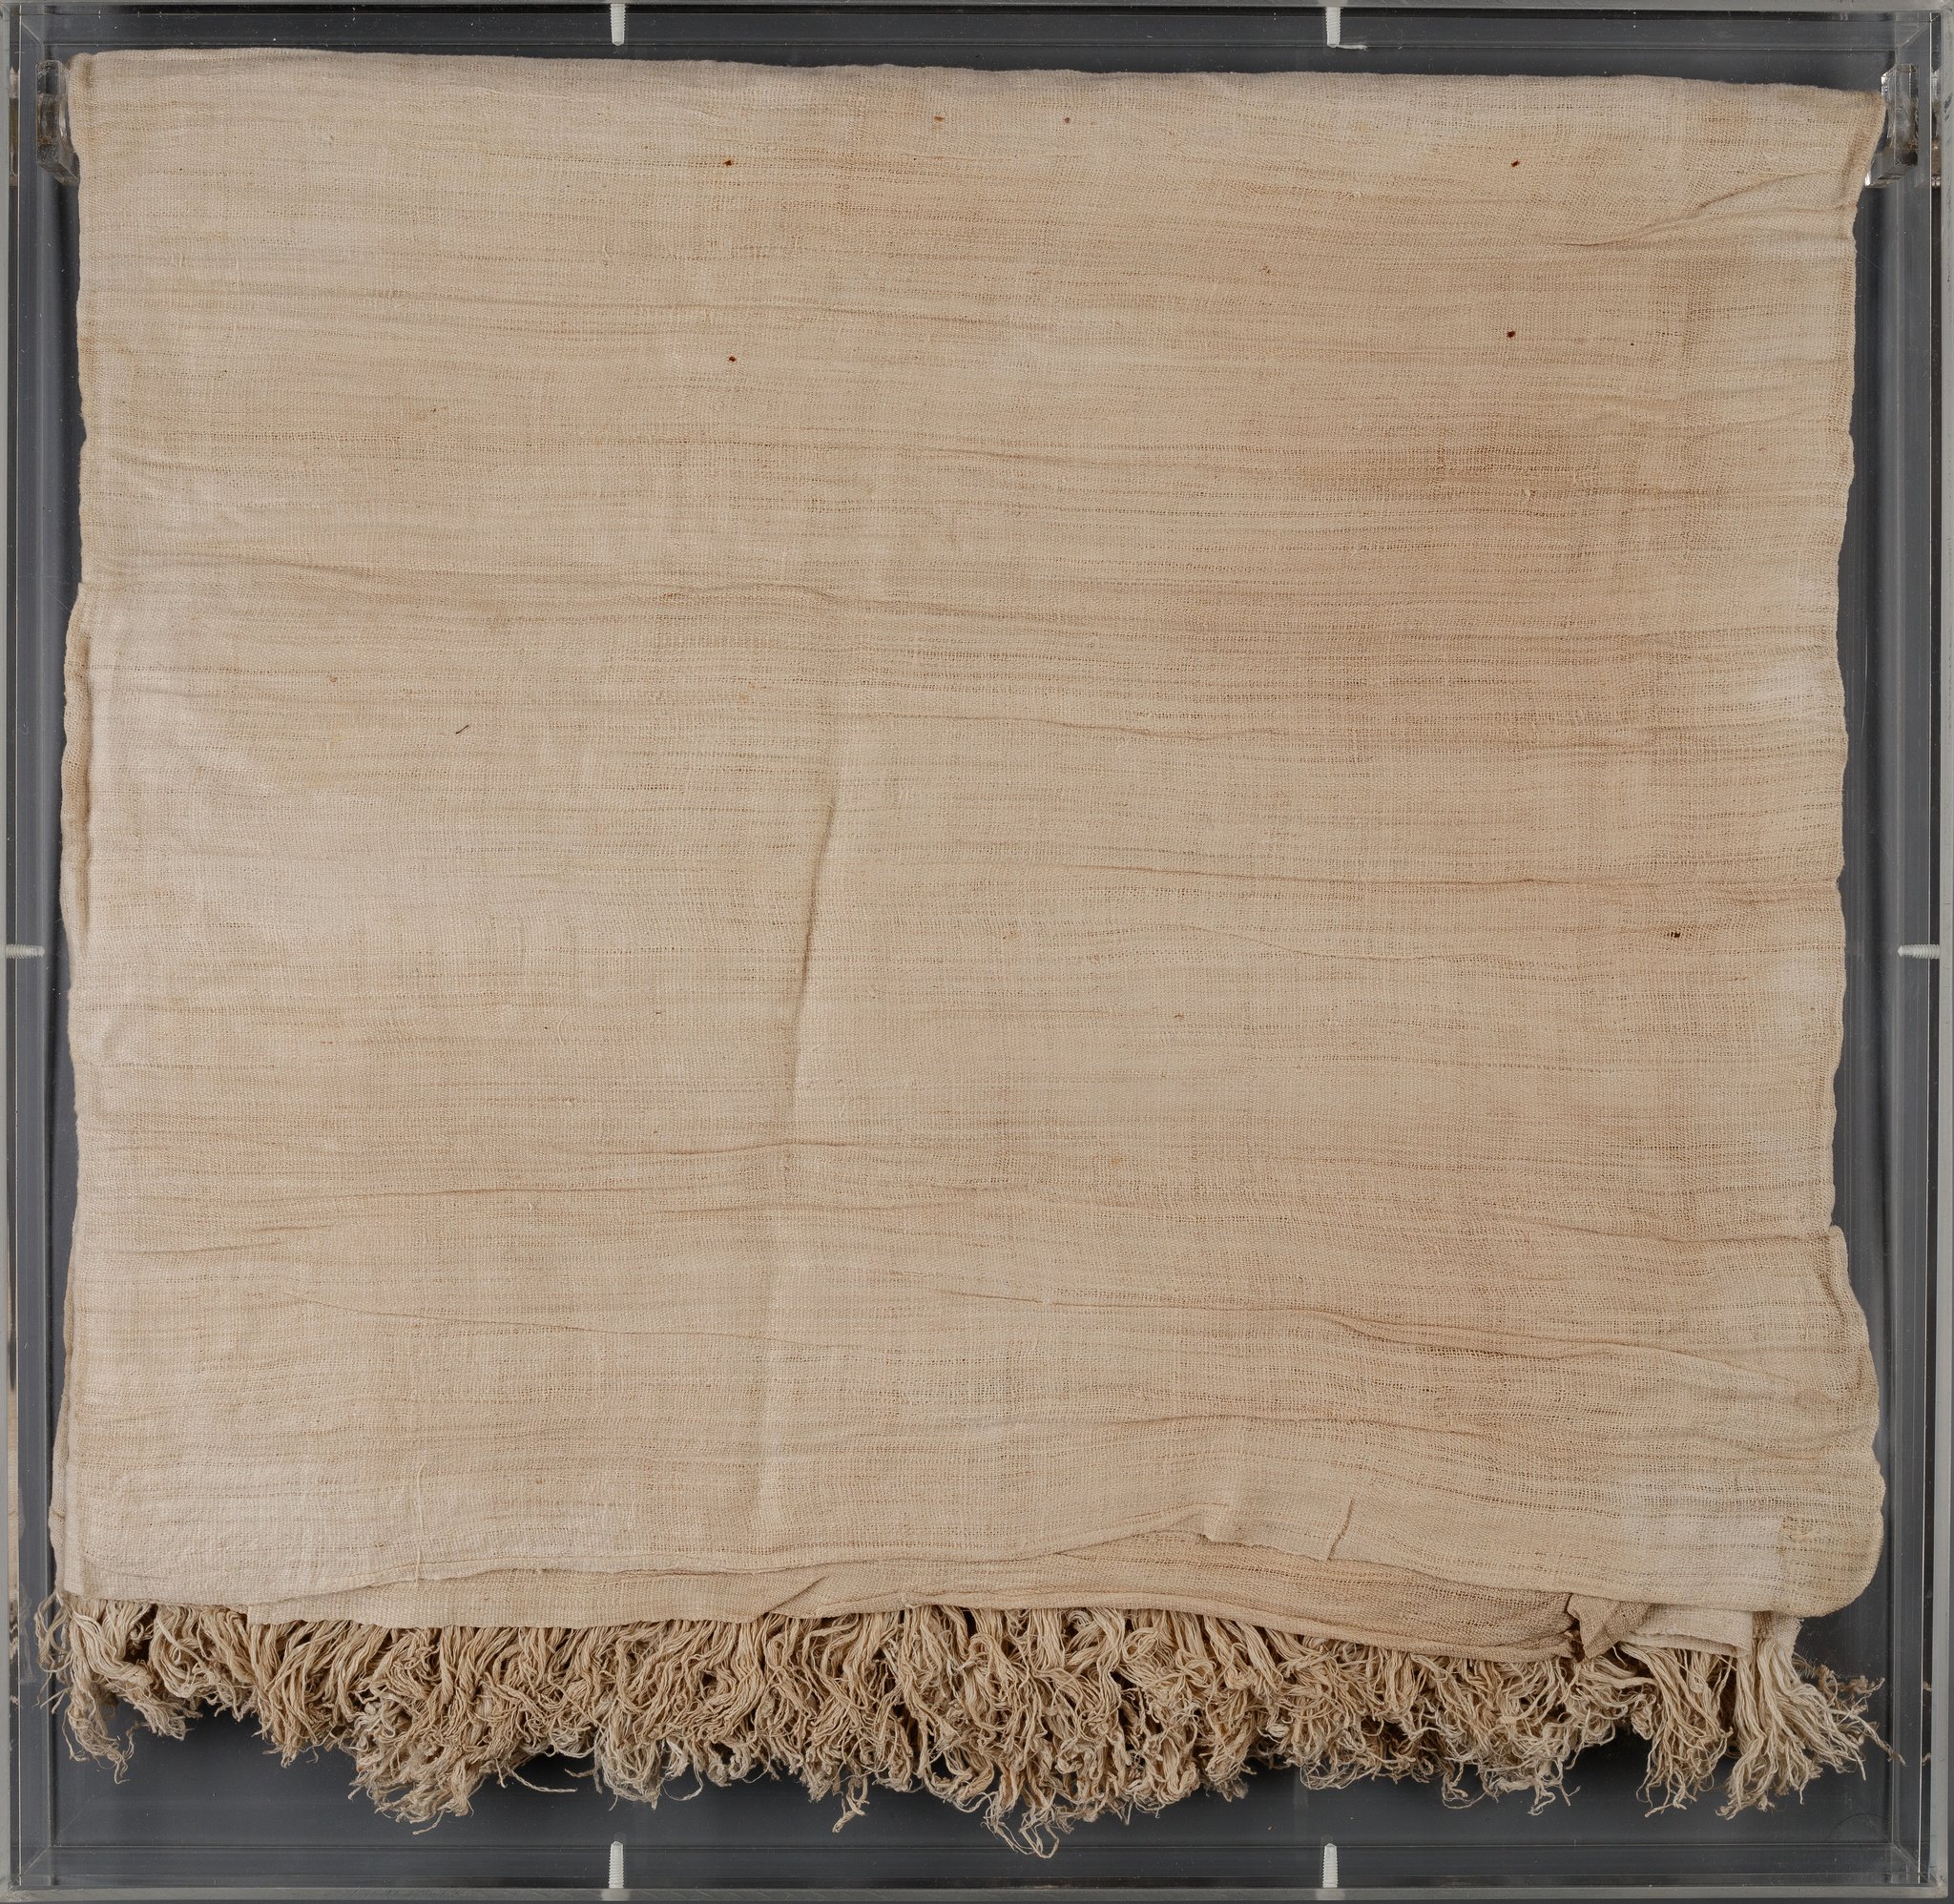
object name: linen cloth, plain weave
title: Plain weave linen cloth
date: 2649-2465 BCE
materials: linen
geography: egypt